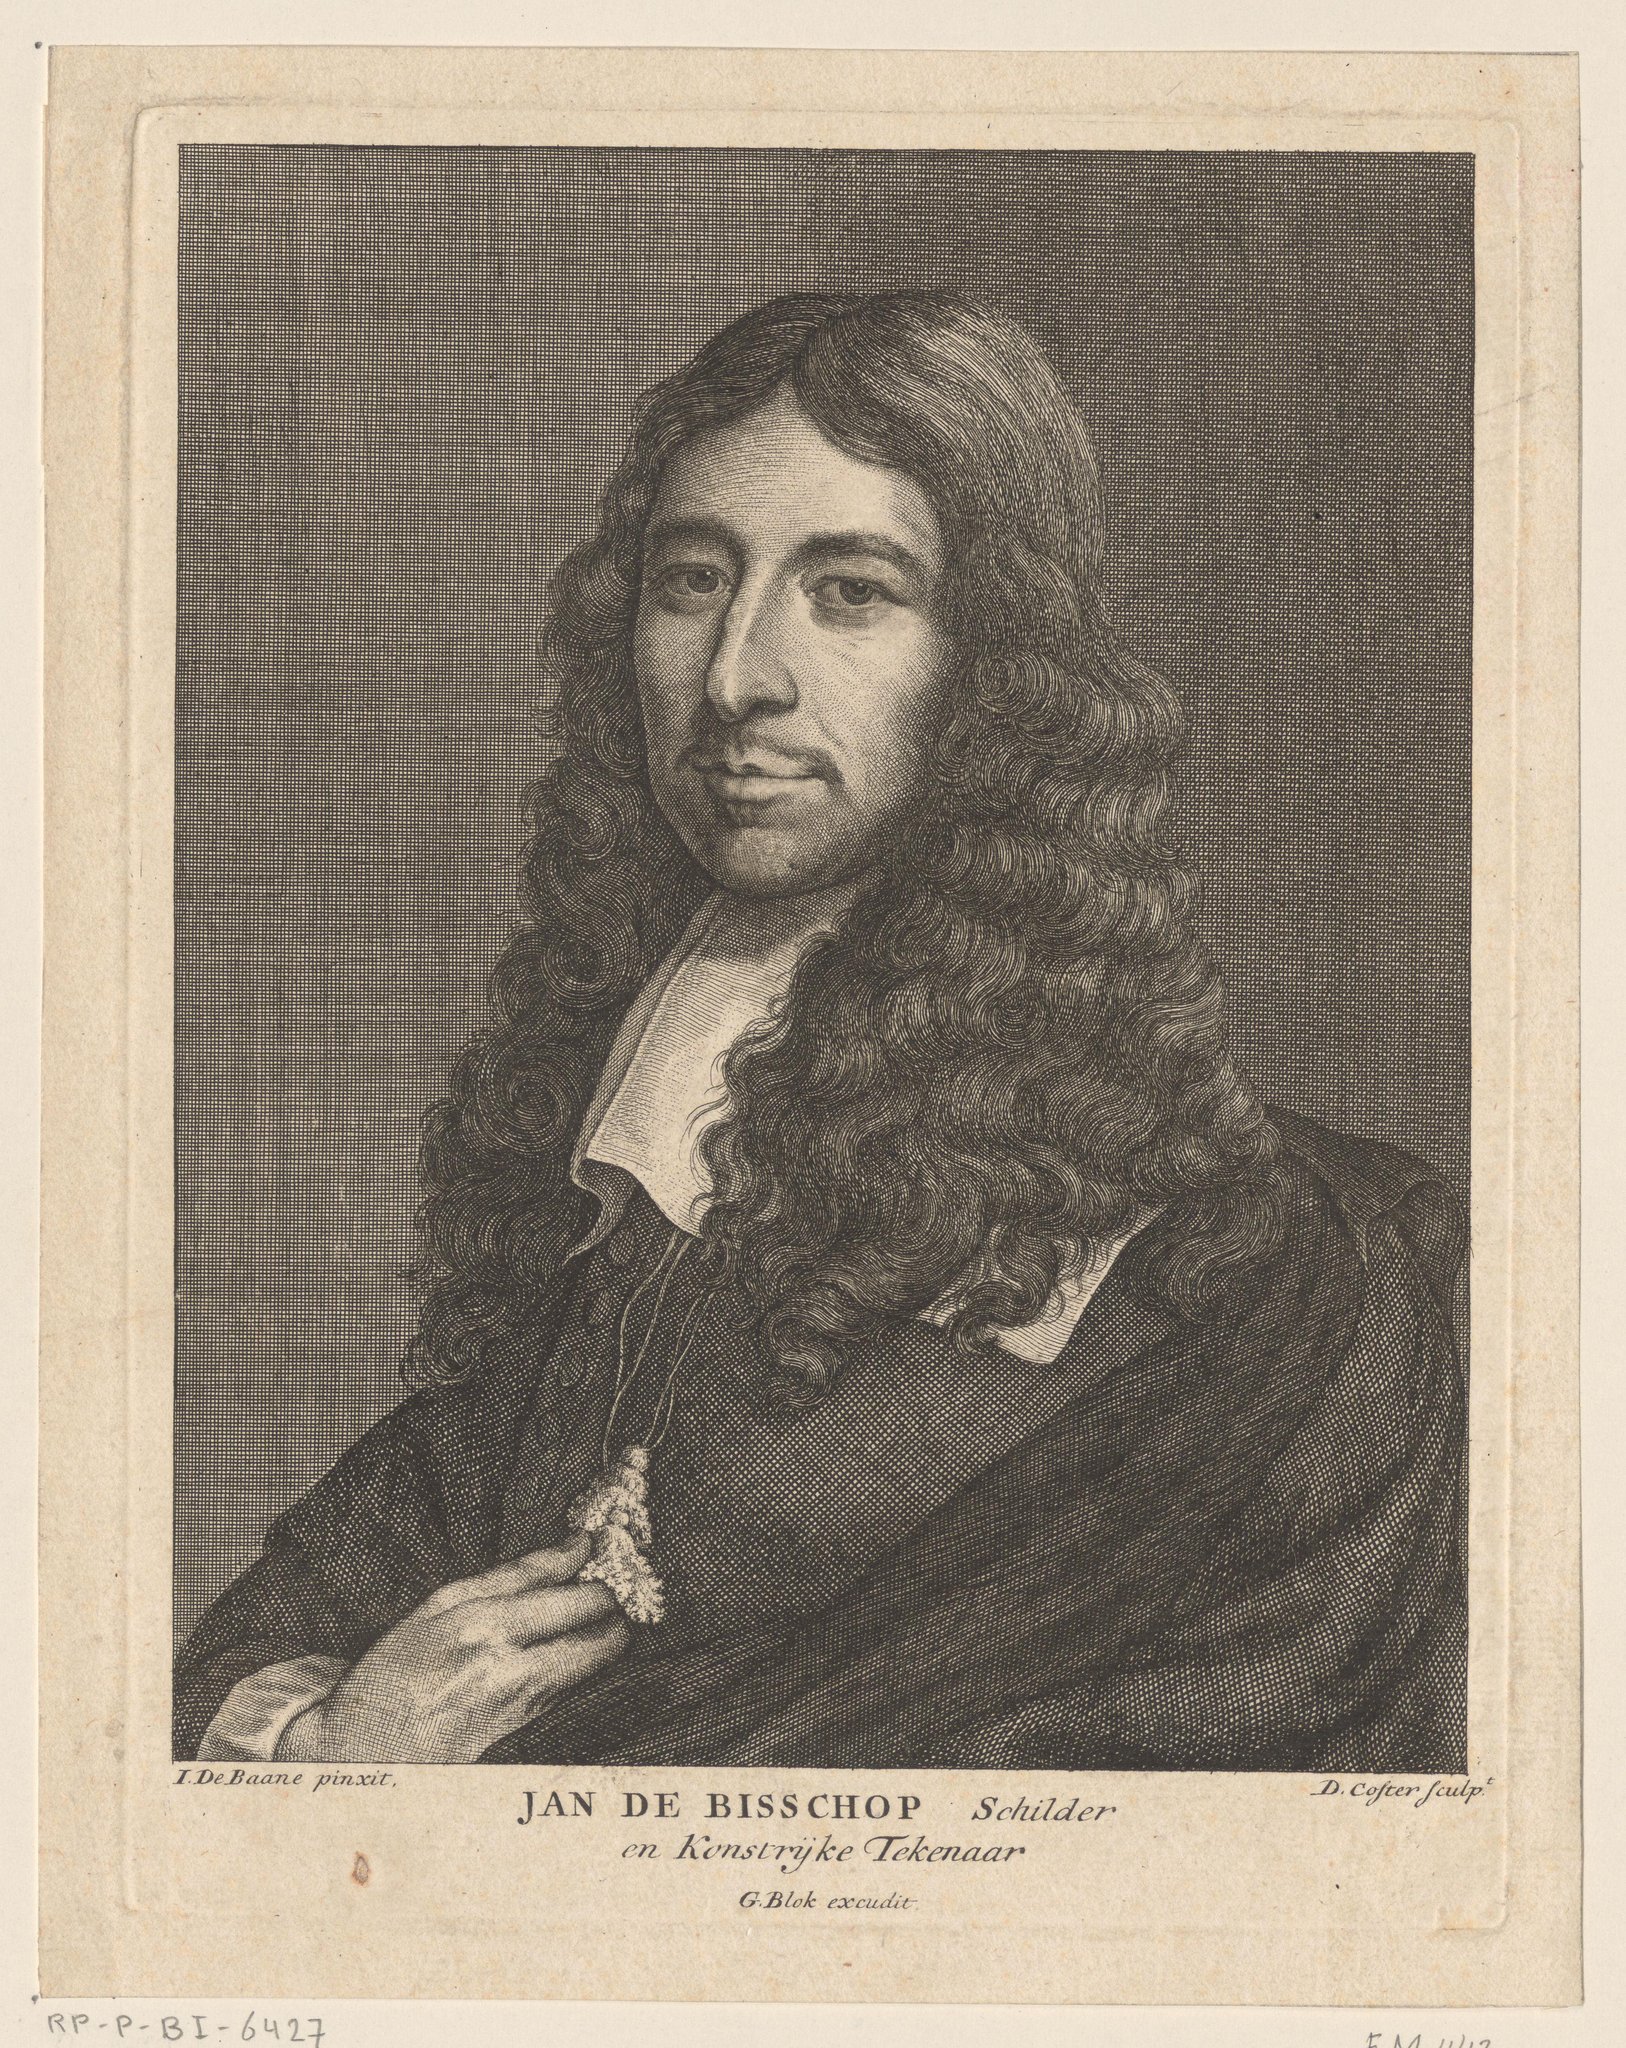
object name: print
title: Portret van Jan de Bisschop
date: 1732-1743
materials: paper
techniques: engraving, etching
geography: the hague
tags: amsterdam, the hague, draughtsman, jan de bisschop, historical persons, portrait, self-portrait of painter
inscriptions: collector's mark: Lugt 2228